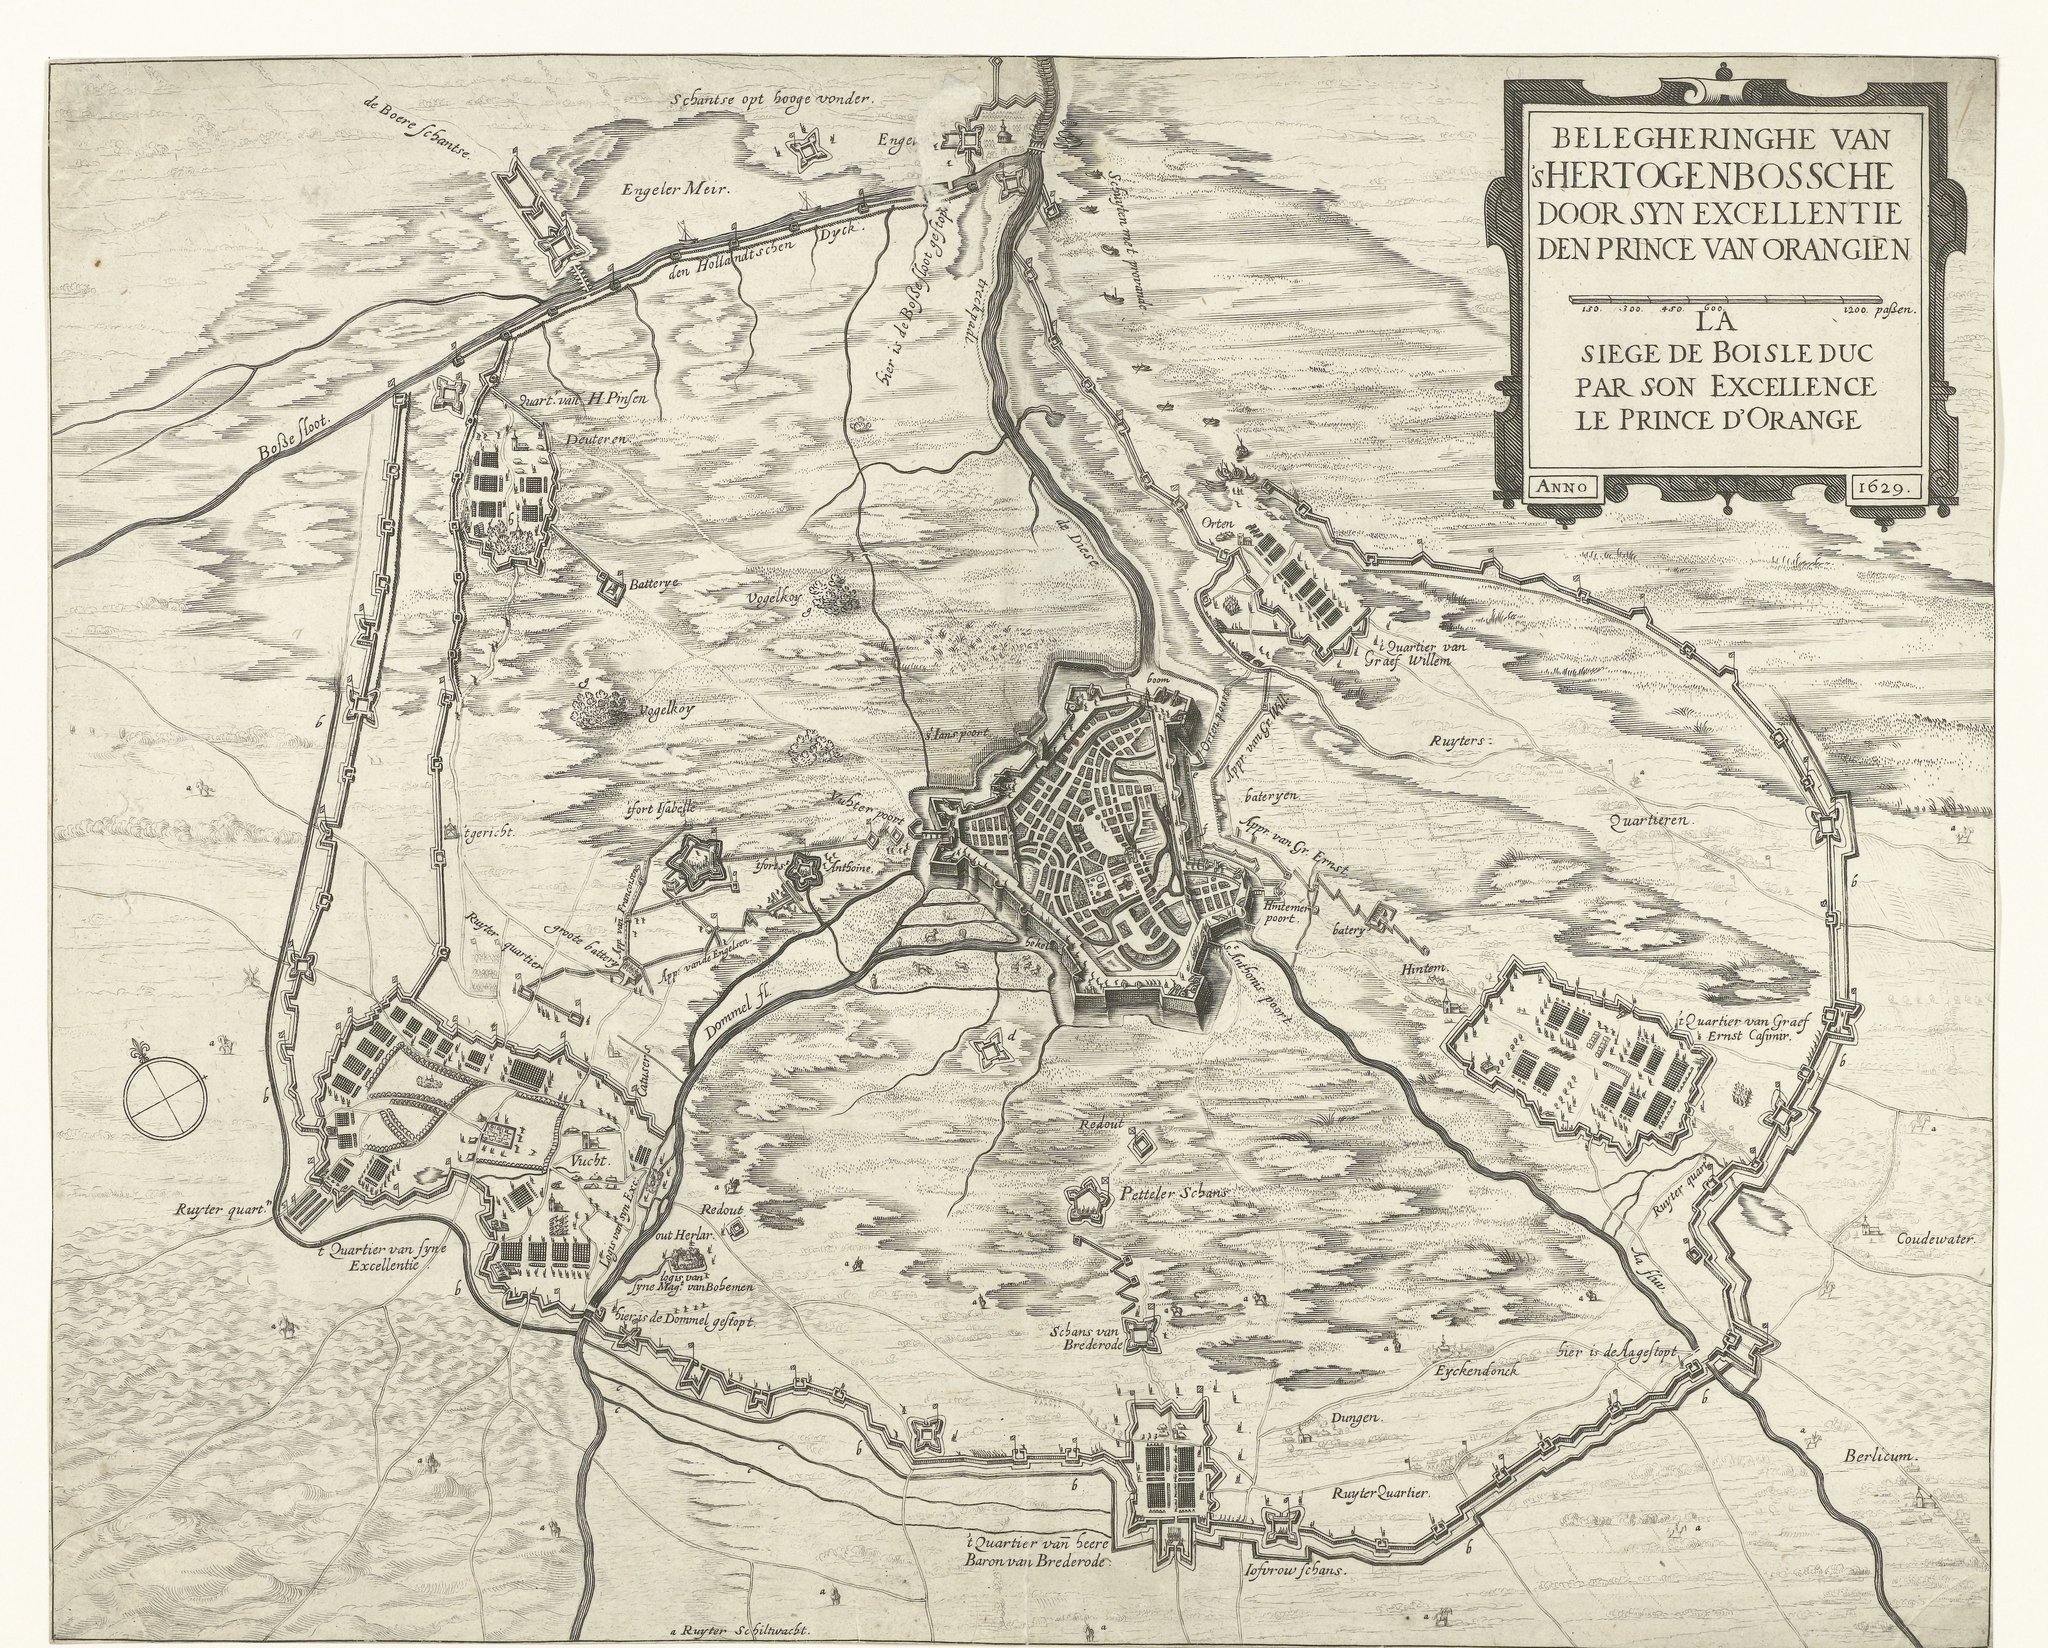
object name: print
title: Kaart van het beleg van Den Bosch door Frederik Hendrik, 1629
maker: Anonymous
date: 1629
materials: paper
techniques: engraving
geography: northern netherlands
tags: delft, frederick henry (prince of orange), maps of separate countries or regions, siege, position war, den bosch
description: Kaart van Den Bosch en omgeving tijdens de omsingeling en het beleg door het Staatse leger onder Frederik Hendrik, van 1 mei tot 17 september 1629. Met de vijf legerkampen van de belegerende legers. Rechtsboven een cartouche met de titels.